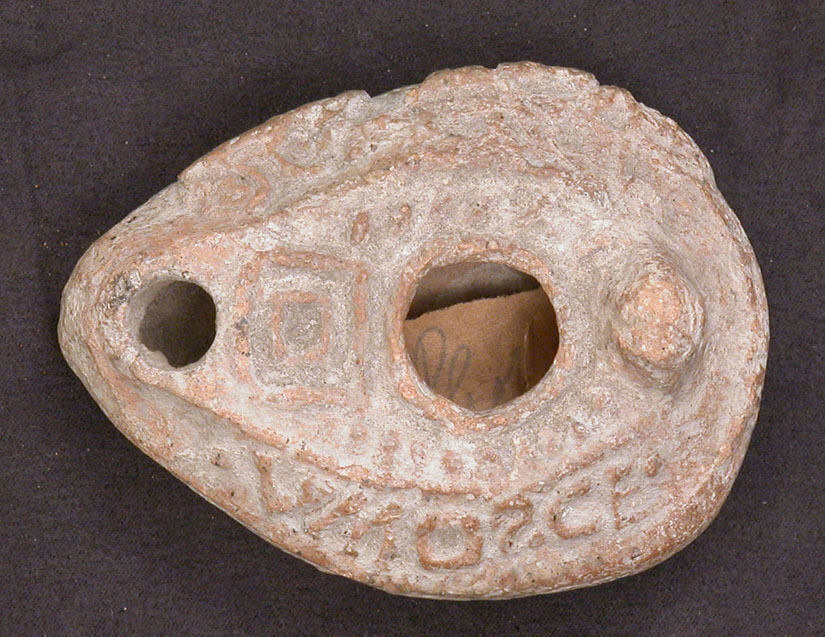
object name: lamp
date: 601-800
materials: earthenware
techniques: molding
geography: palestine